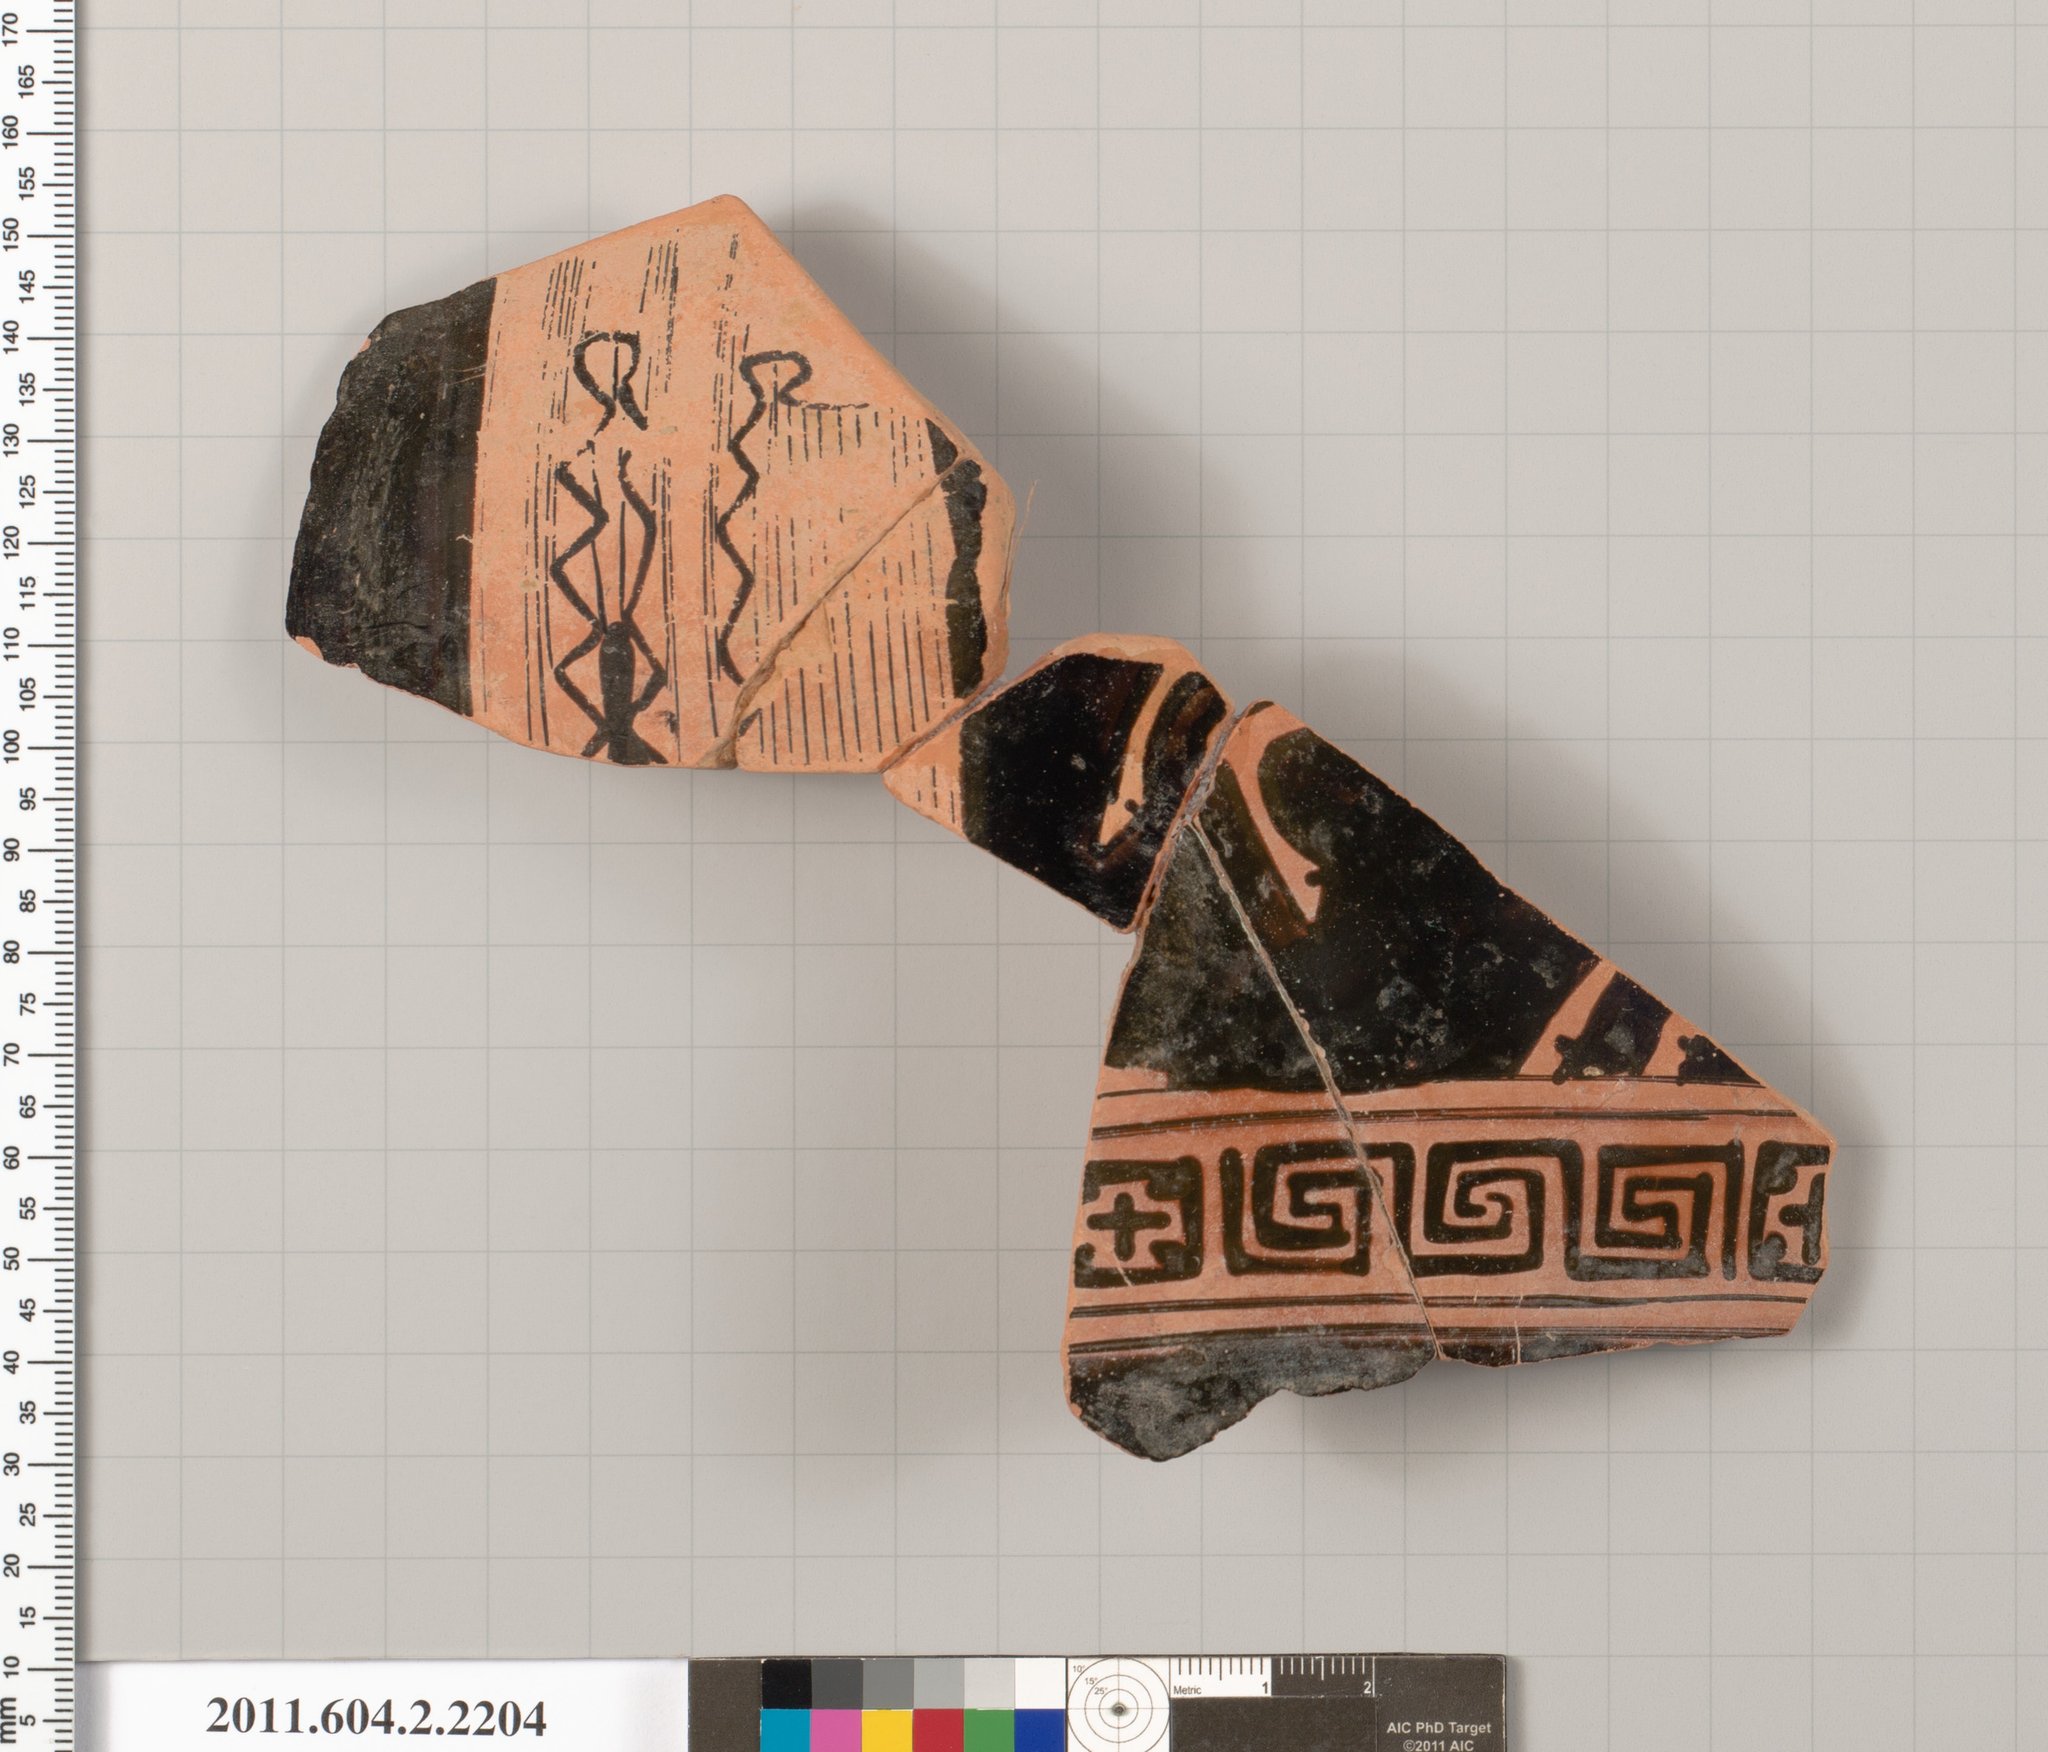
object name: pot fragment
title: Terracotta fragment of a pot; unglazed on the inside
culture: greek, attic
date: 475-451 BCE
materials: terracotta